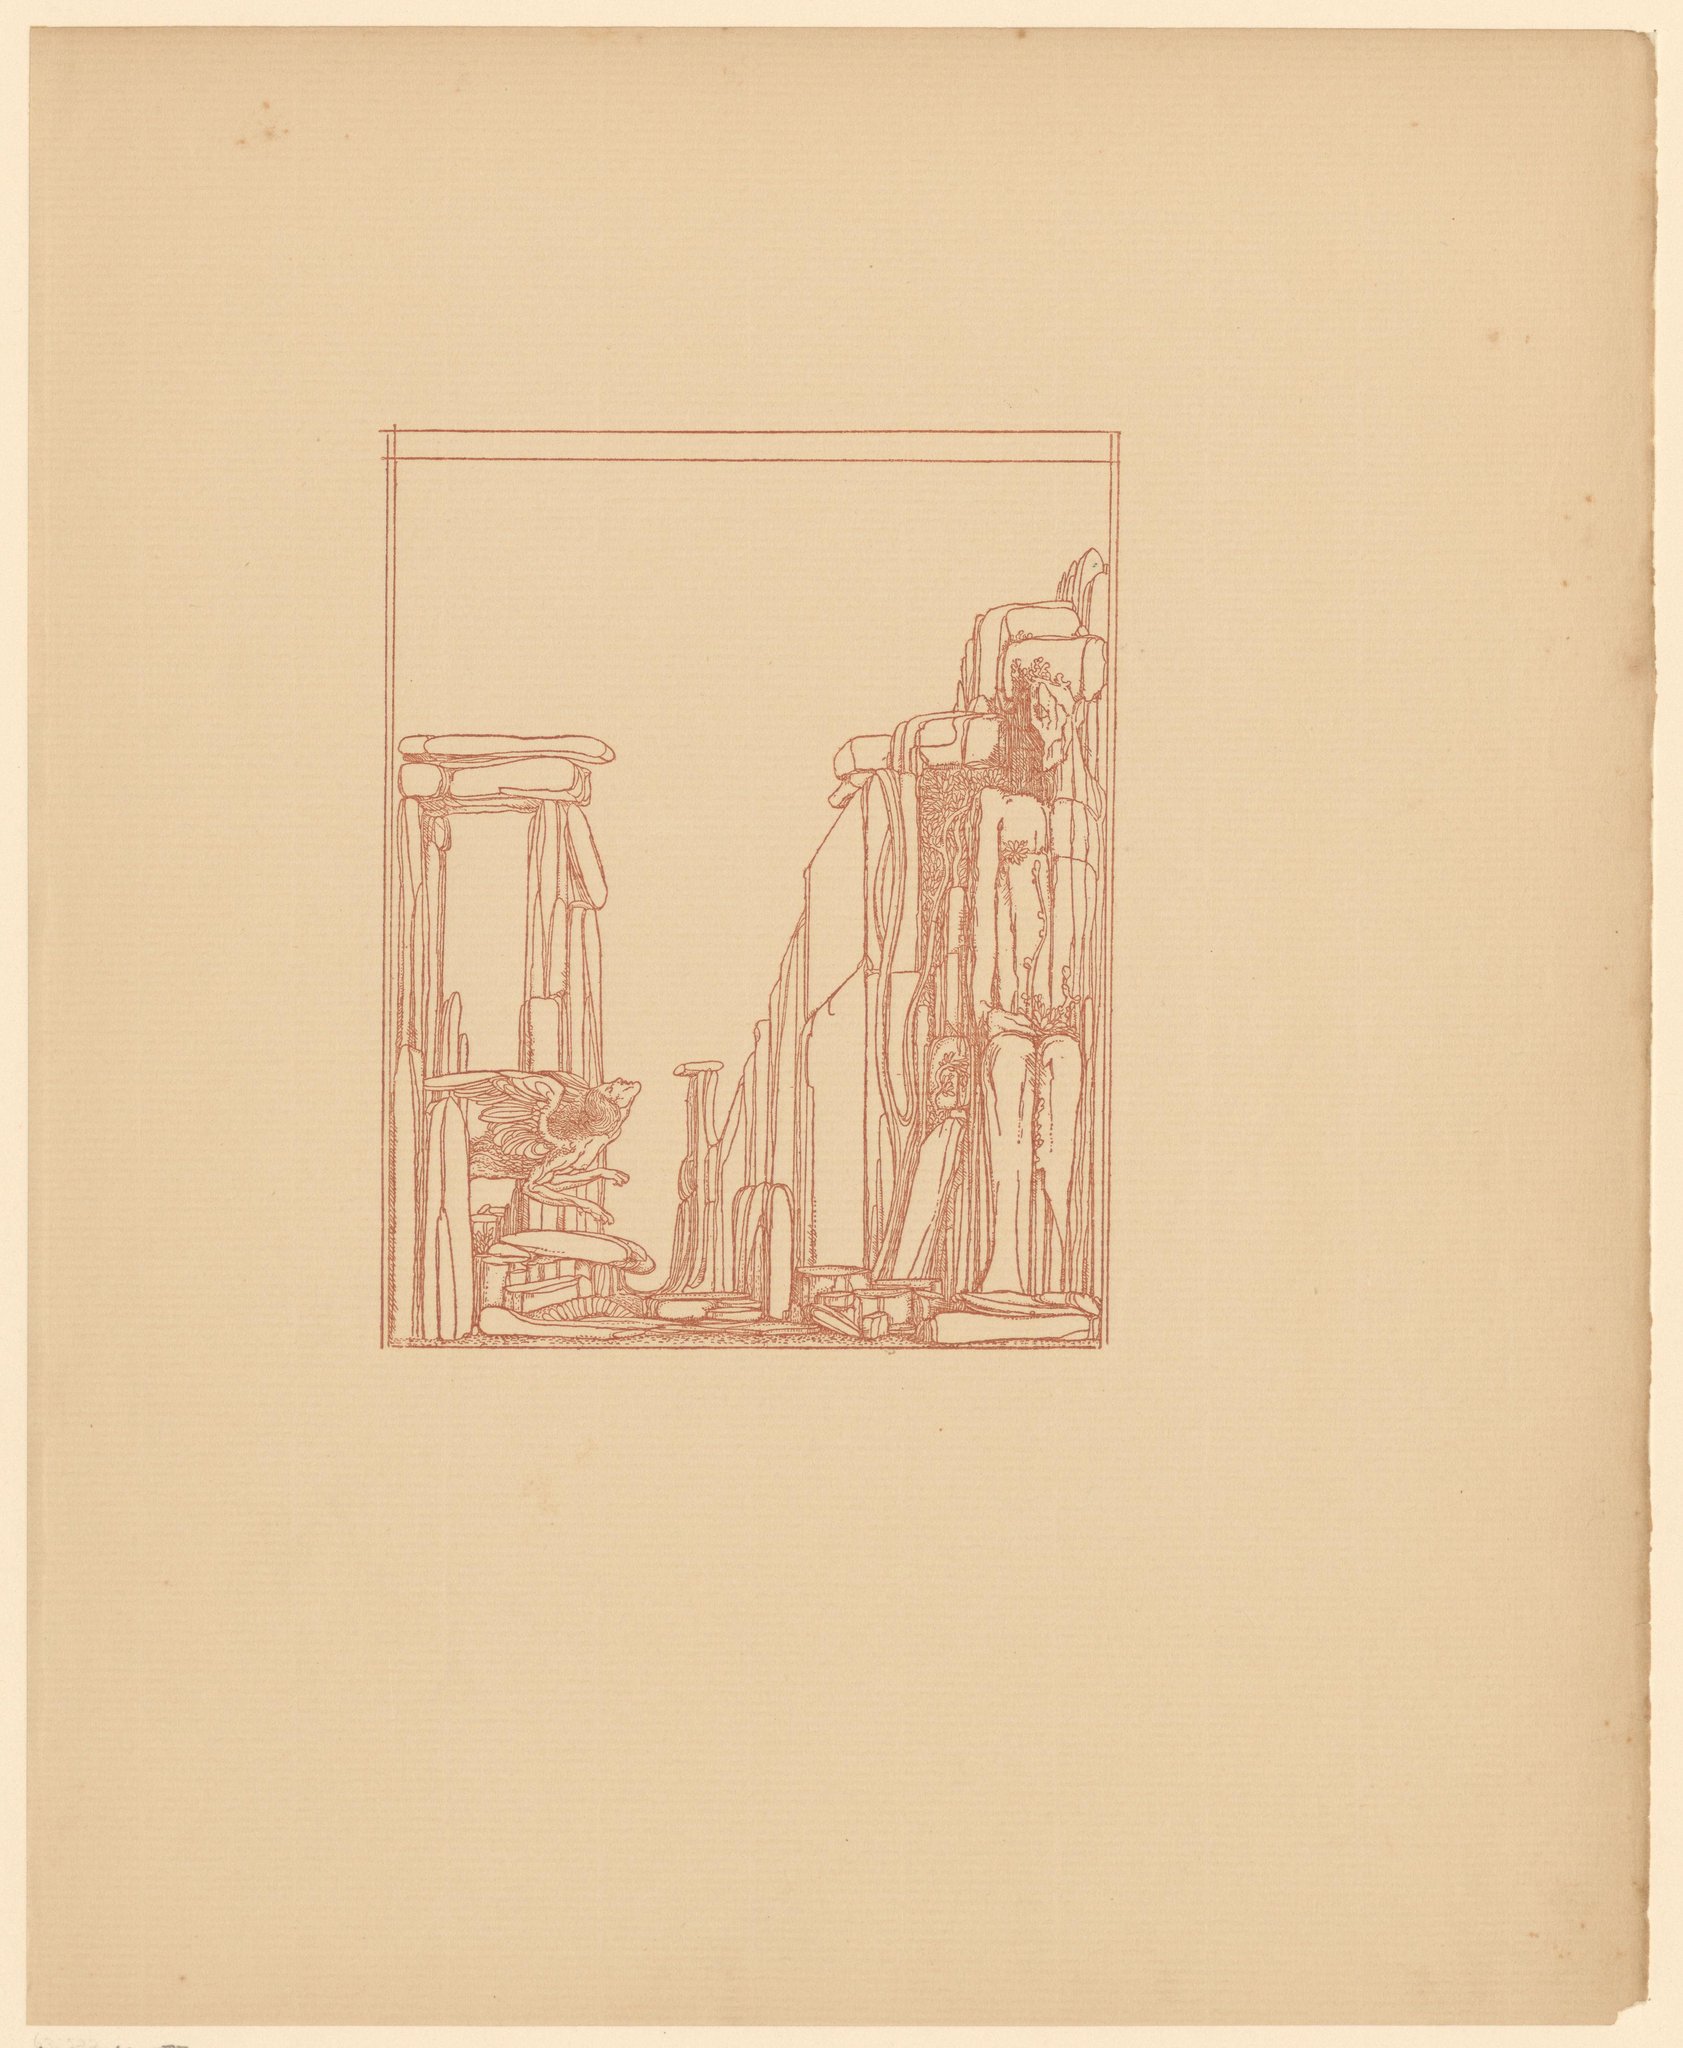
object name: photomechanical print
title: In the Thebaid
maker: Anonymous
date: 1893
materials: paper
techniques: printing block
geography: london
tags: sphinx (lion/woman); 'sfinge' (ripa) - aa - female human figure, landscape with ruins, rocks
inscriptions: collector's mark: Lugt 2228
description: Prent uit: The Dial 3 (1893). De prent is ook gebruikt als illustratie bij het gedicht 'The Sphinx' van Oscar Wilde.